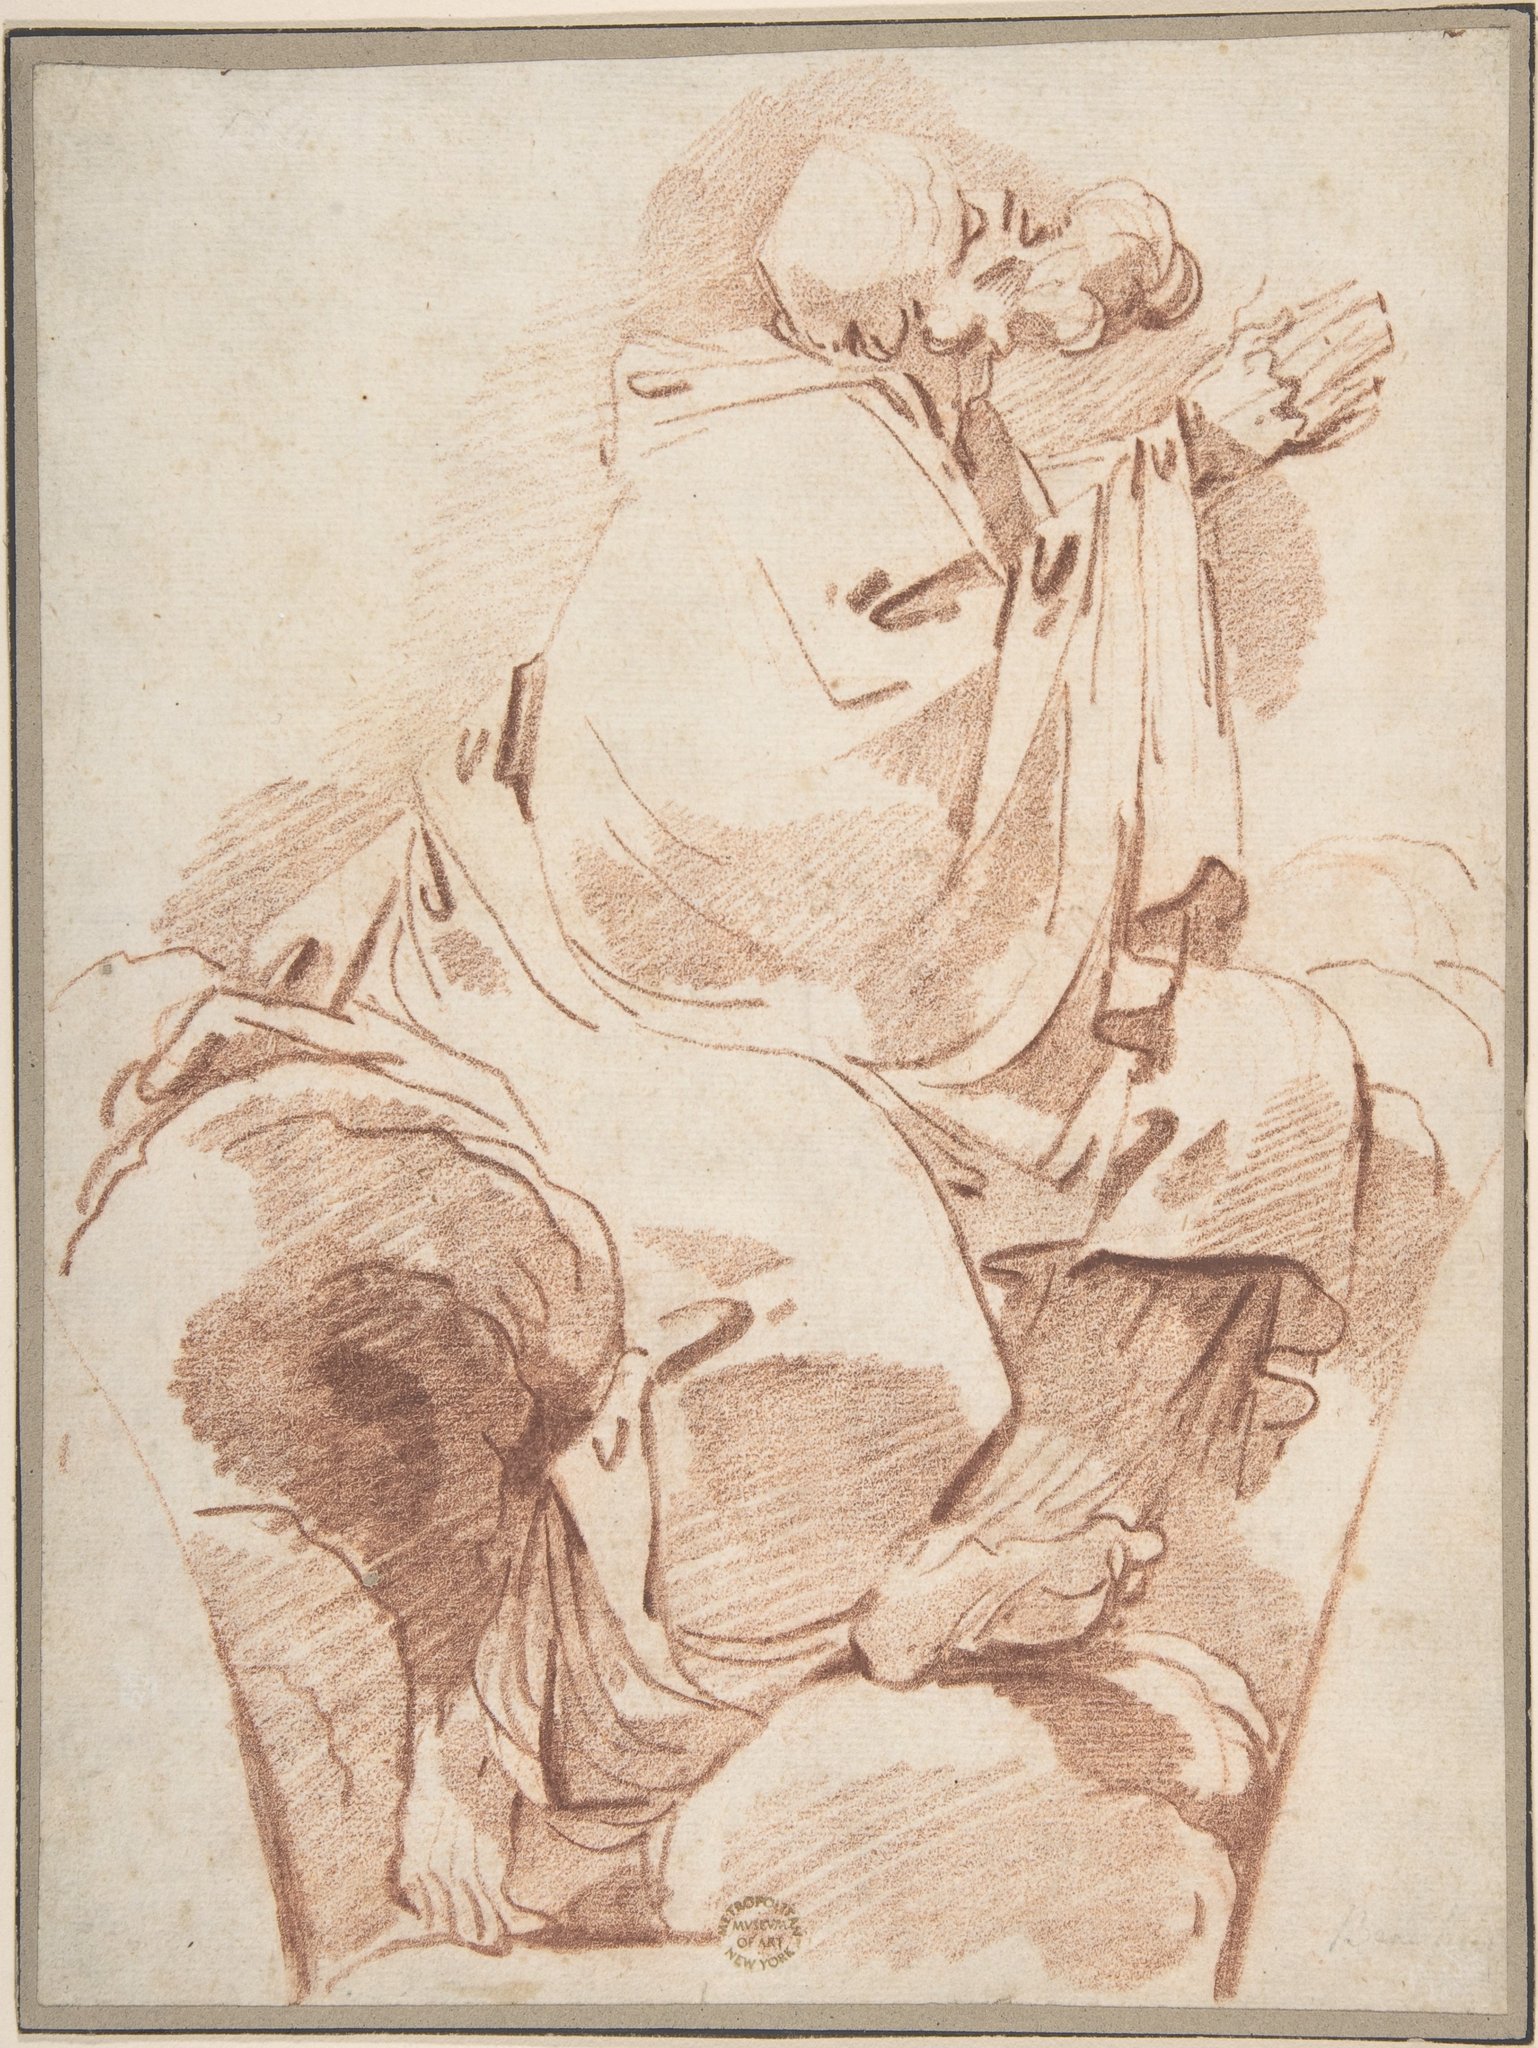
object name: drawing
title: Prophet Seated in Profile on a Cloudbank, Praying: decoration for a spandrel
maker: andré lebrun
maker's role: artist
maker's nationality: french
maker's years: 1737-1811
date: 1760-1790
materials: chalk, paper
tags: men,praying